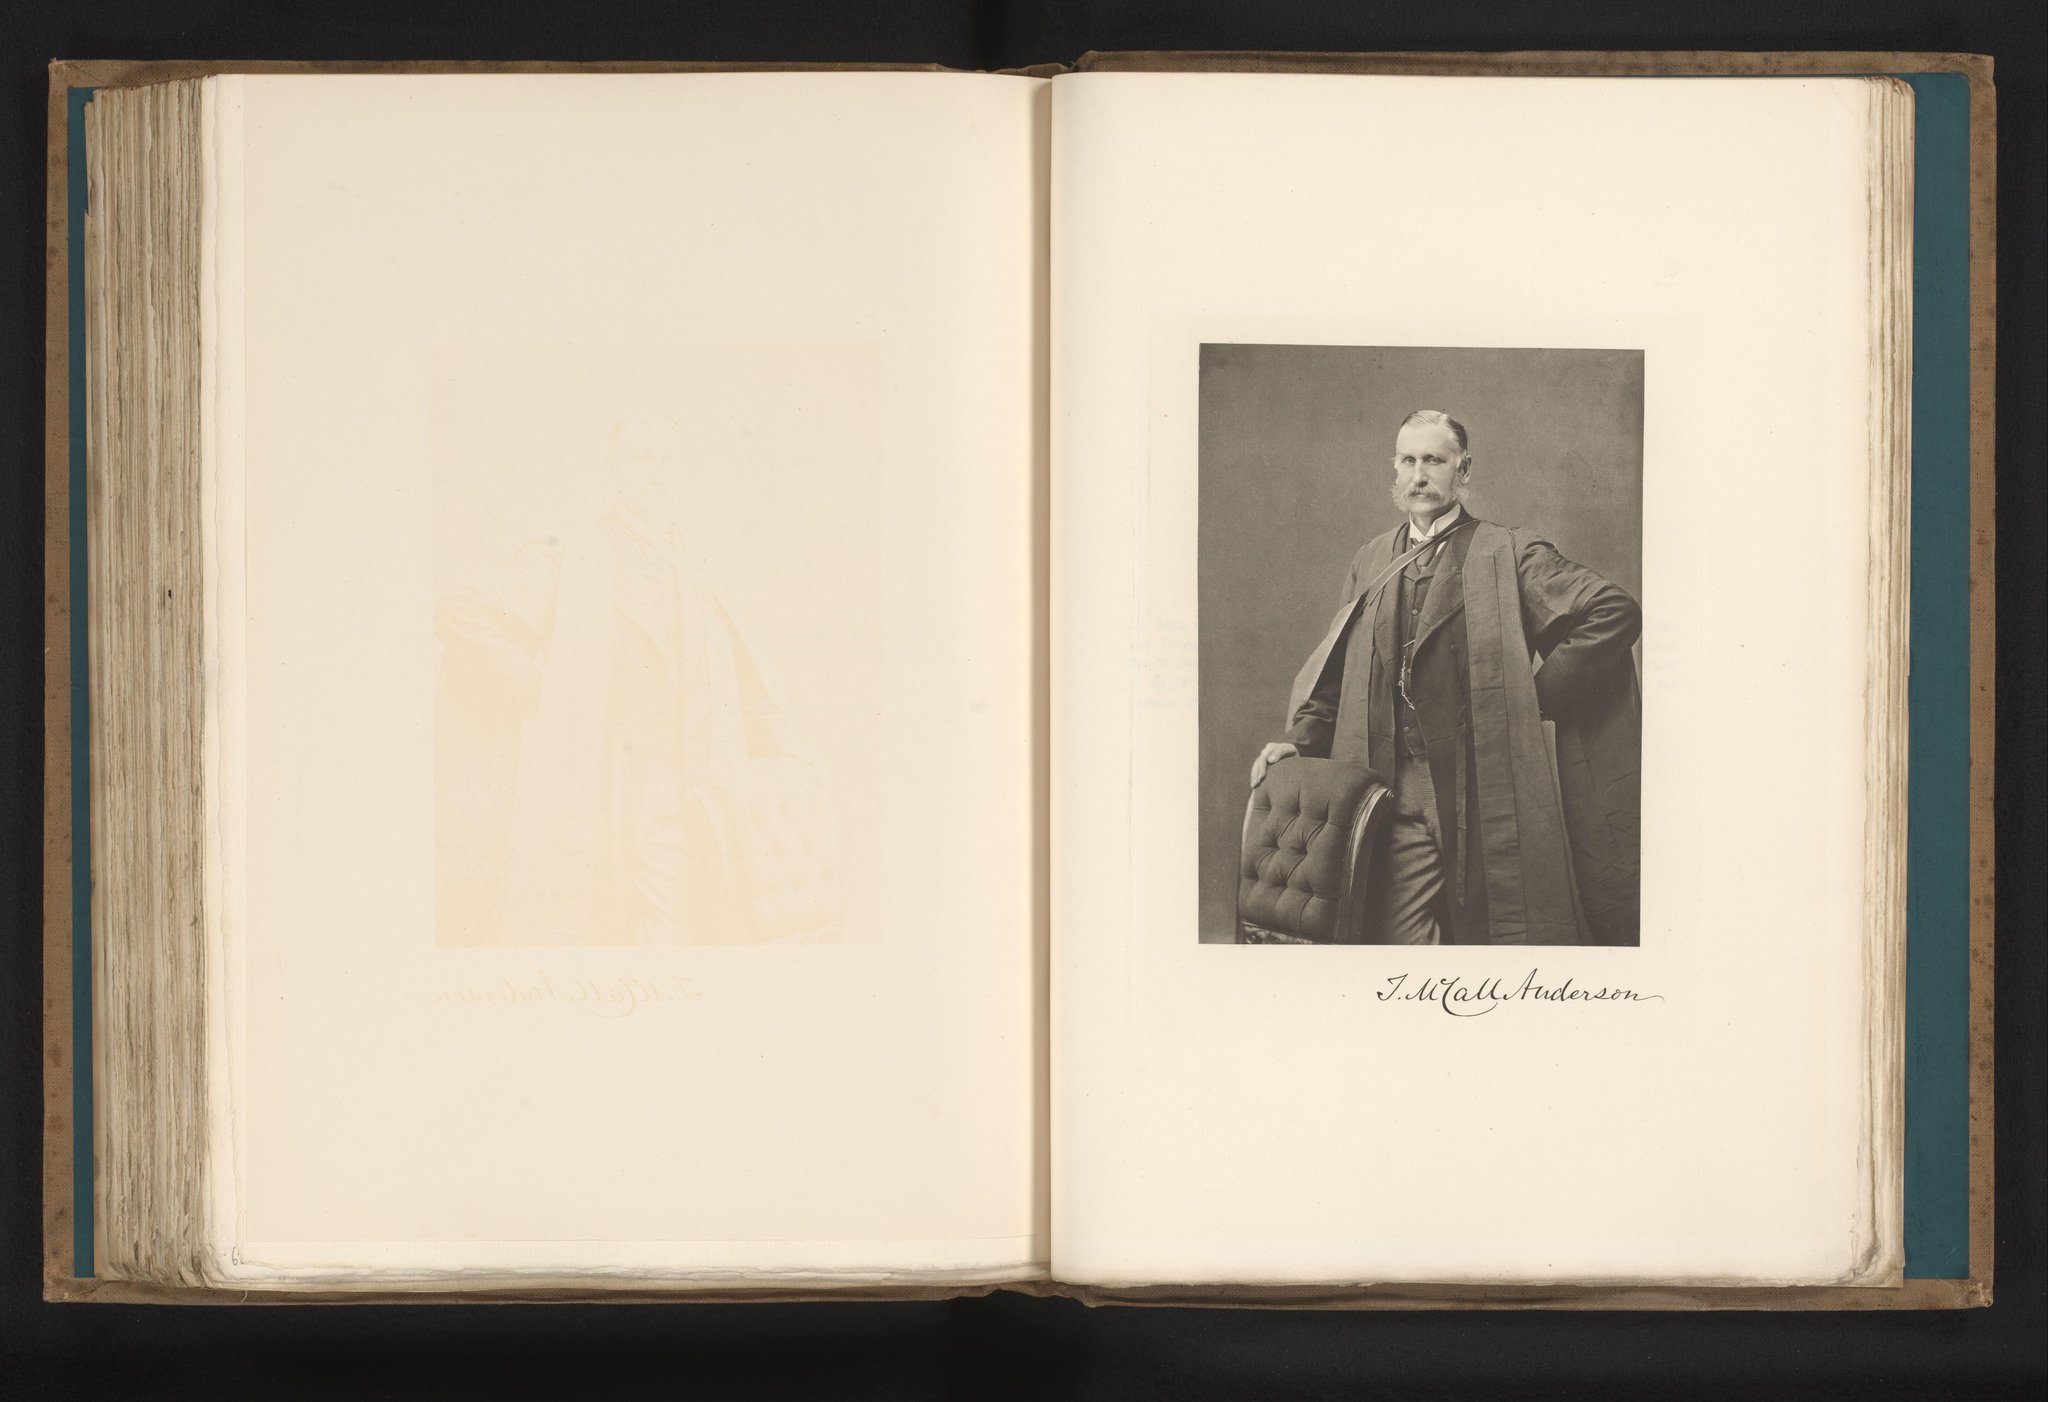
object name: photomechanical print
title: Portret van Thomas McCall Anderson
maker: Anonymous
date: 1886-1891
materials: paper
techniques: photoaquatint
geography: glasgow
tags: historical persons, physician, doctor, professor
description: Prent op zeventiende ongenummerde pagina na pagina 128.